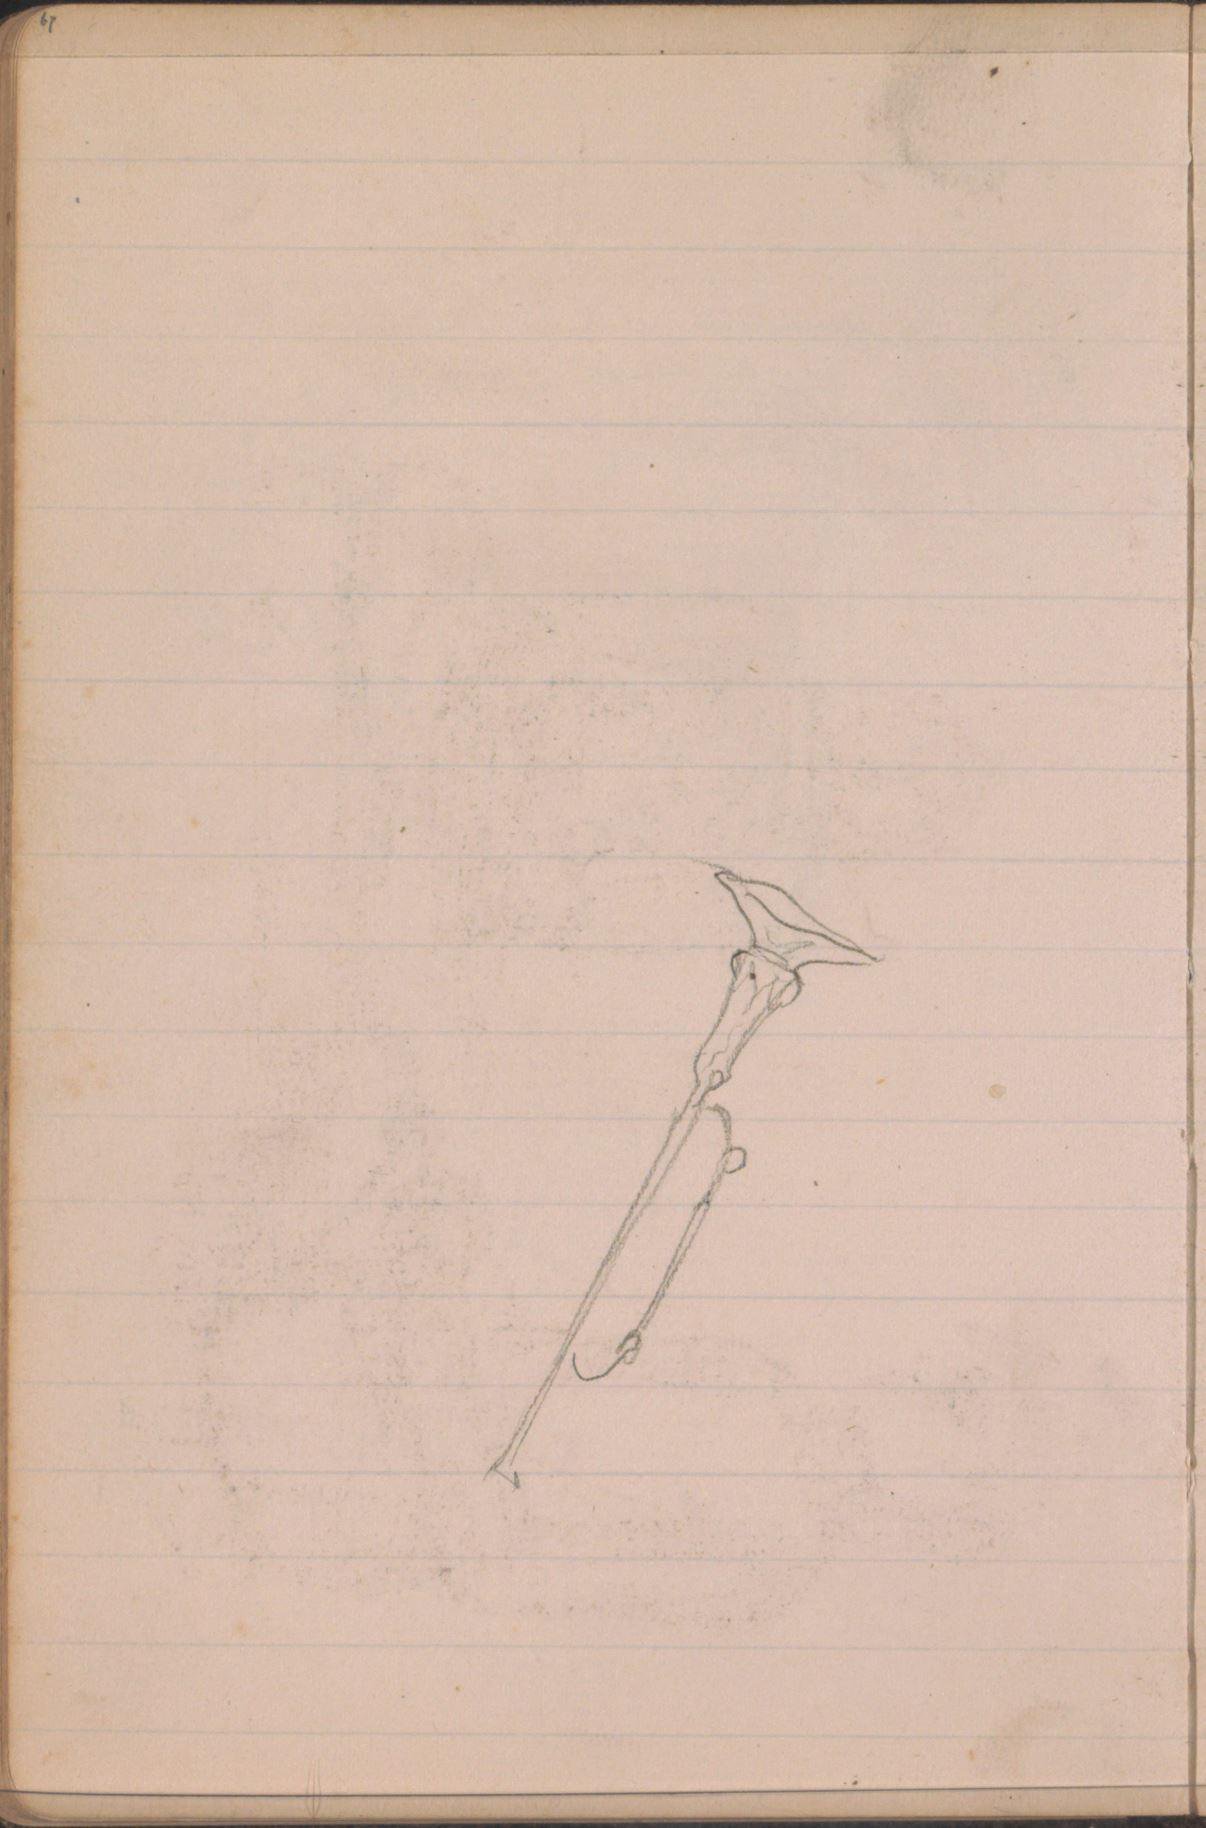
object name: sketchbook leaf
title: Object met een toeter, mogelijk een muziekinstrument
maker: marius bauer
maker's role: draughtsman, print maker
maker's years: 1867-1932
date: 1897-1898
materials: pencil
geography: india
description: Mogelijk heeft het object een functie binnen de Jaïnistische religie. Pagina 67 uit een schetsboek met 84 bladen.